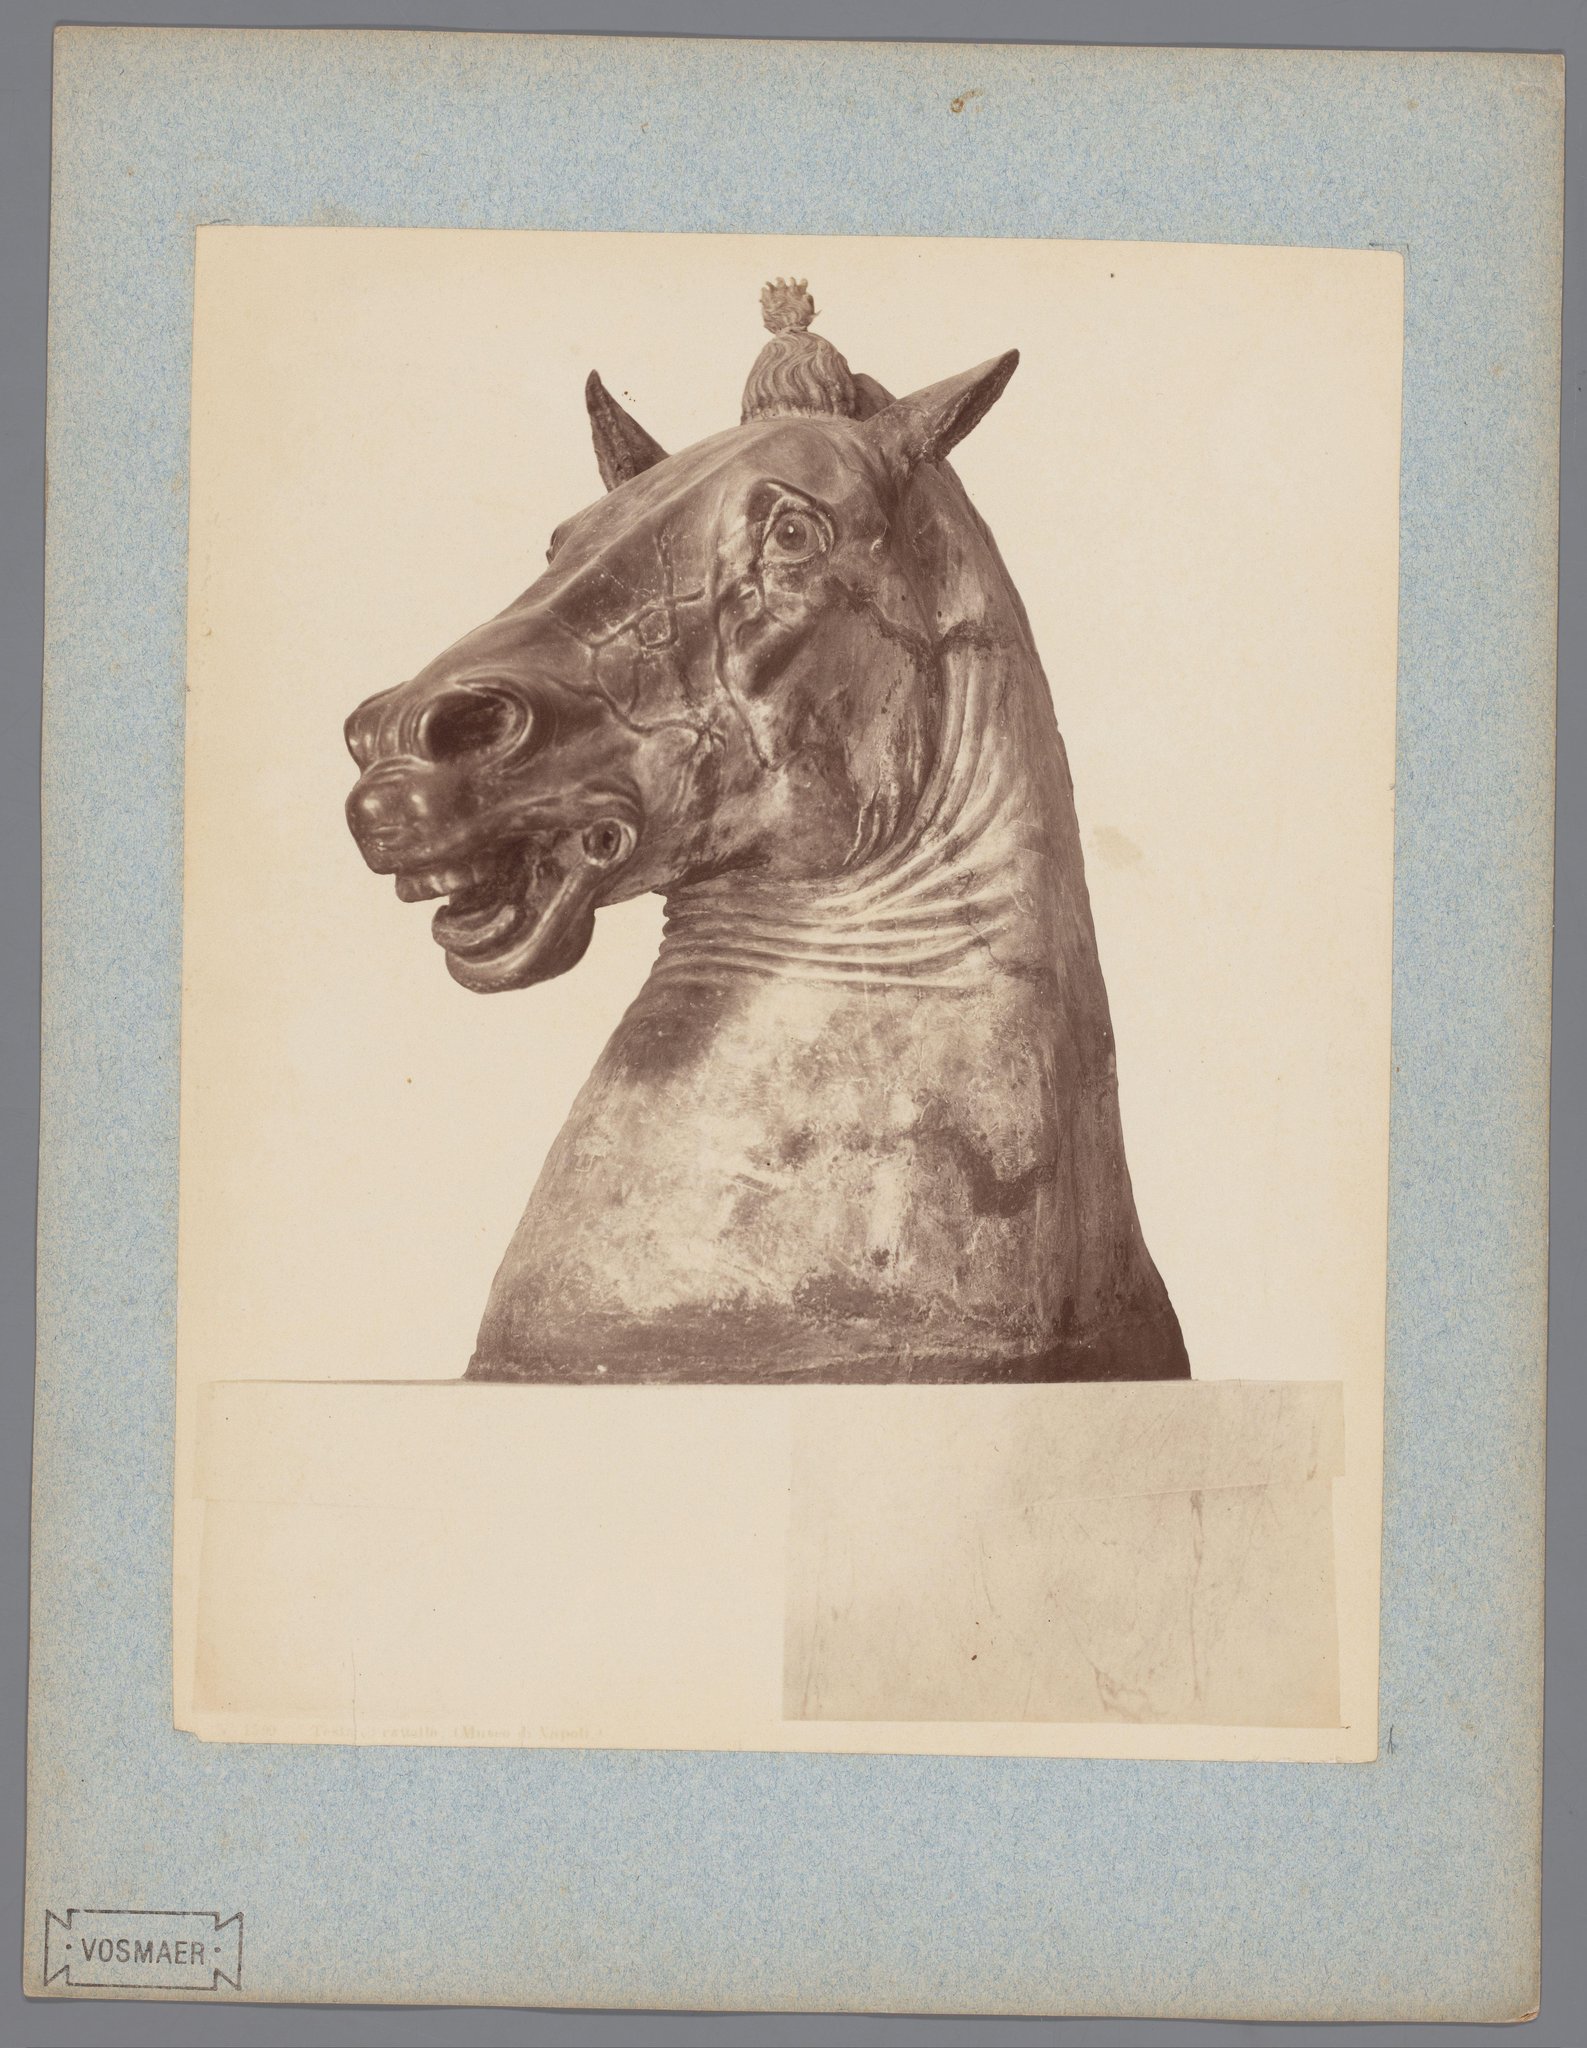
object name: photograph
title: Sculptuur van paardenhoofd in het Museo Archeologico Nazionale te Napels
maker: giorgio sommer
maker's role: fotograaf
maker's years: 1834-1914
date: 1857-1914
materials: cardboard, paper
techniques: albumen print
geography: naples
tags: piece of sculpture, reproduction of a piece of sculpture, horse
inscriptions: inscription: ‘11’, collector's mark: ‘VOSMAER’, number: ‘[...]’